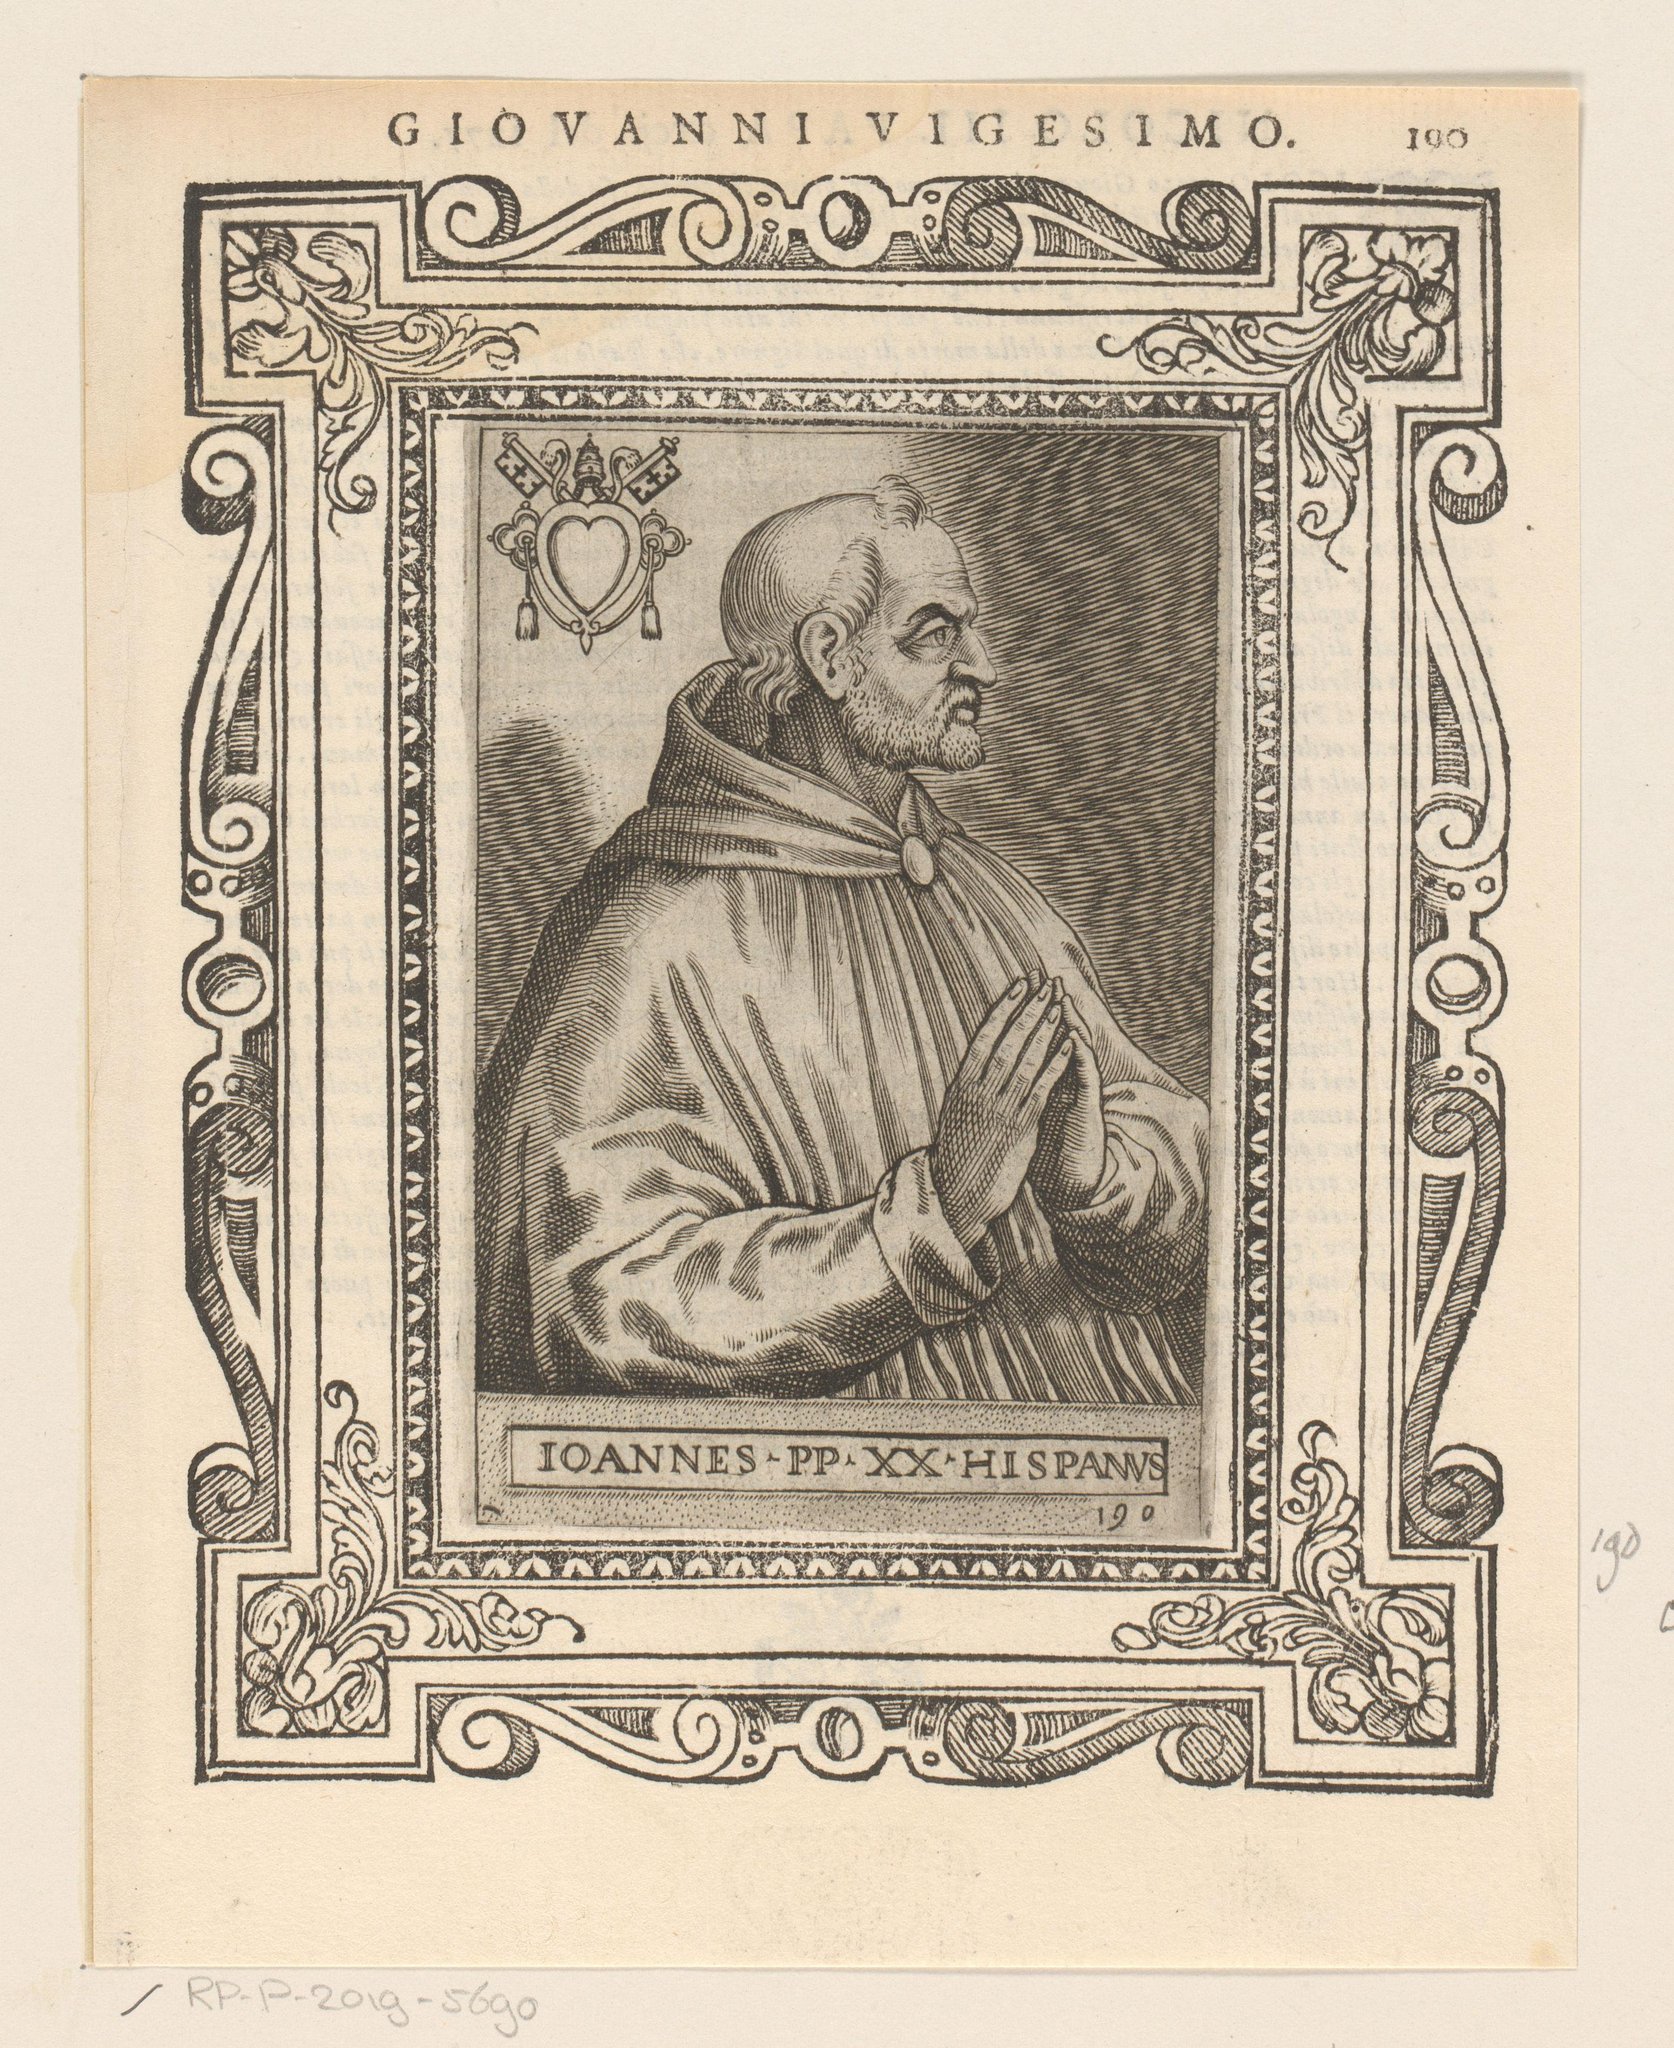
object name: print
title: Portret van paus Johannes XXI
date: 1587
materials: paper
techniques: engraving, letterpress printing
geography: rome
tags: historical persons, pope, armorial bearing, heraldry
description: Prent uit: Ciccarelli, Antonio. Le vite de Pontefici di Antonio Ciccarelli (...). Rome: Domenico Basa, 1587. Prent voor het eerst verschenen in: Cavalieri, Giovanni Battista de'. Pontificum romanorum effigies (...). Rome: Domenico Basa en Francesco Zanetti, 1580. Prent ook gebruikt in latere publicaties.